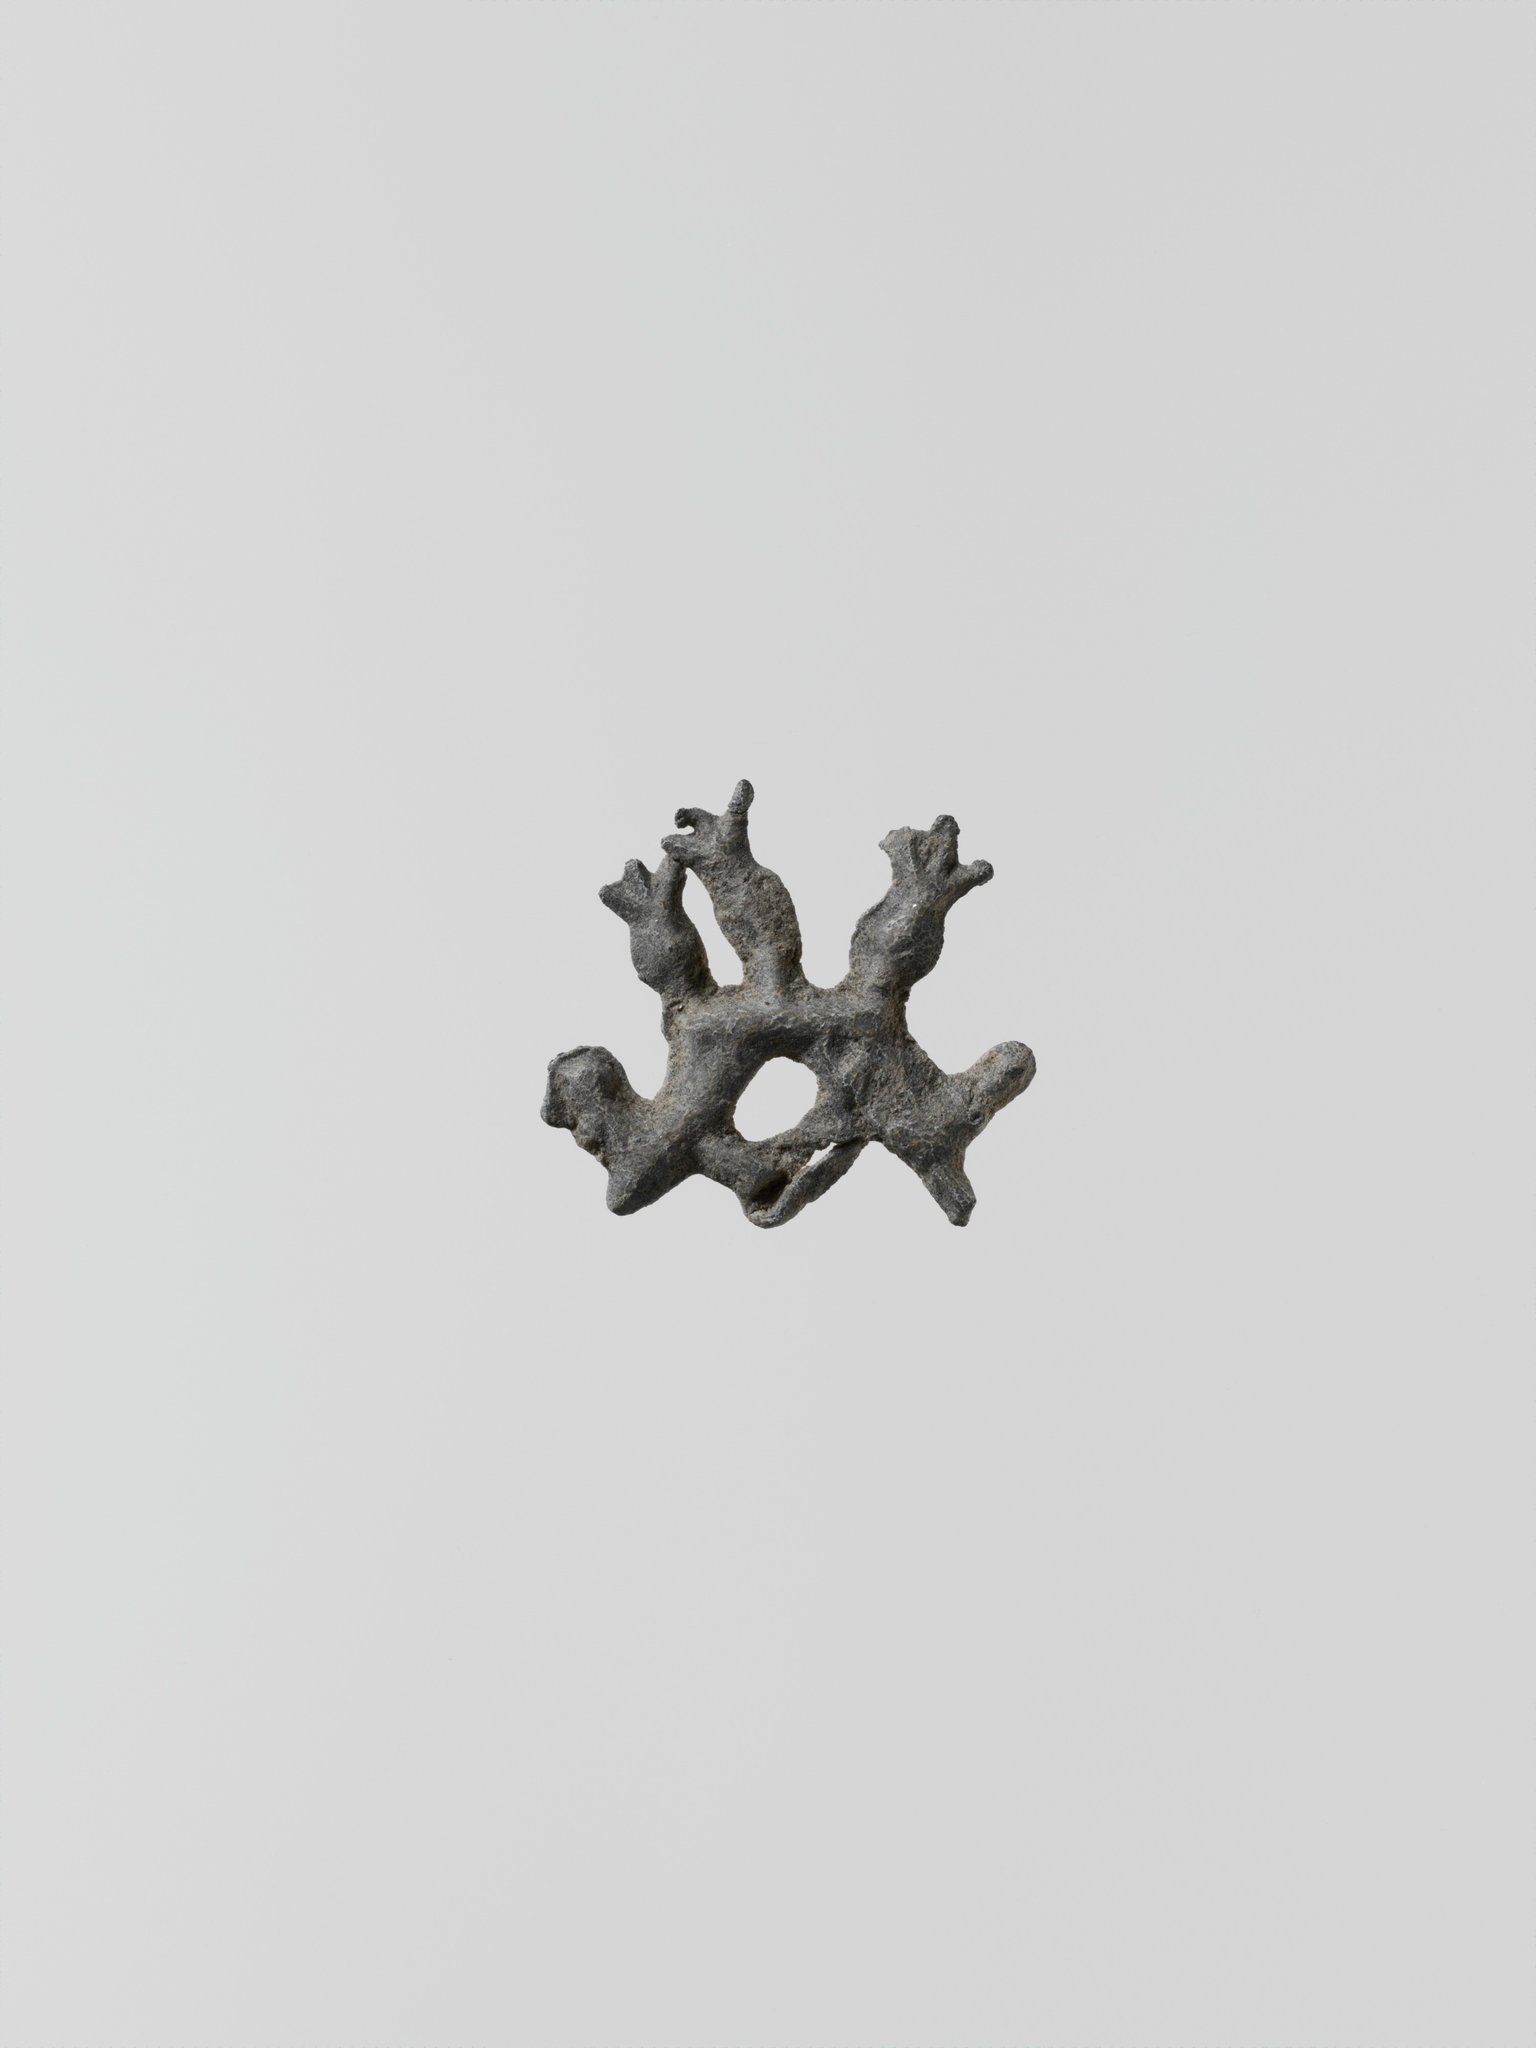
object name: wreath, 6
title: Lead wreath of lotos buds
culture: greek, laconian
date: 600-401 BCE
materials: lead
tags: wreaths